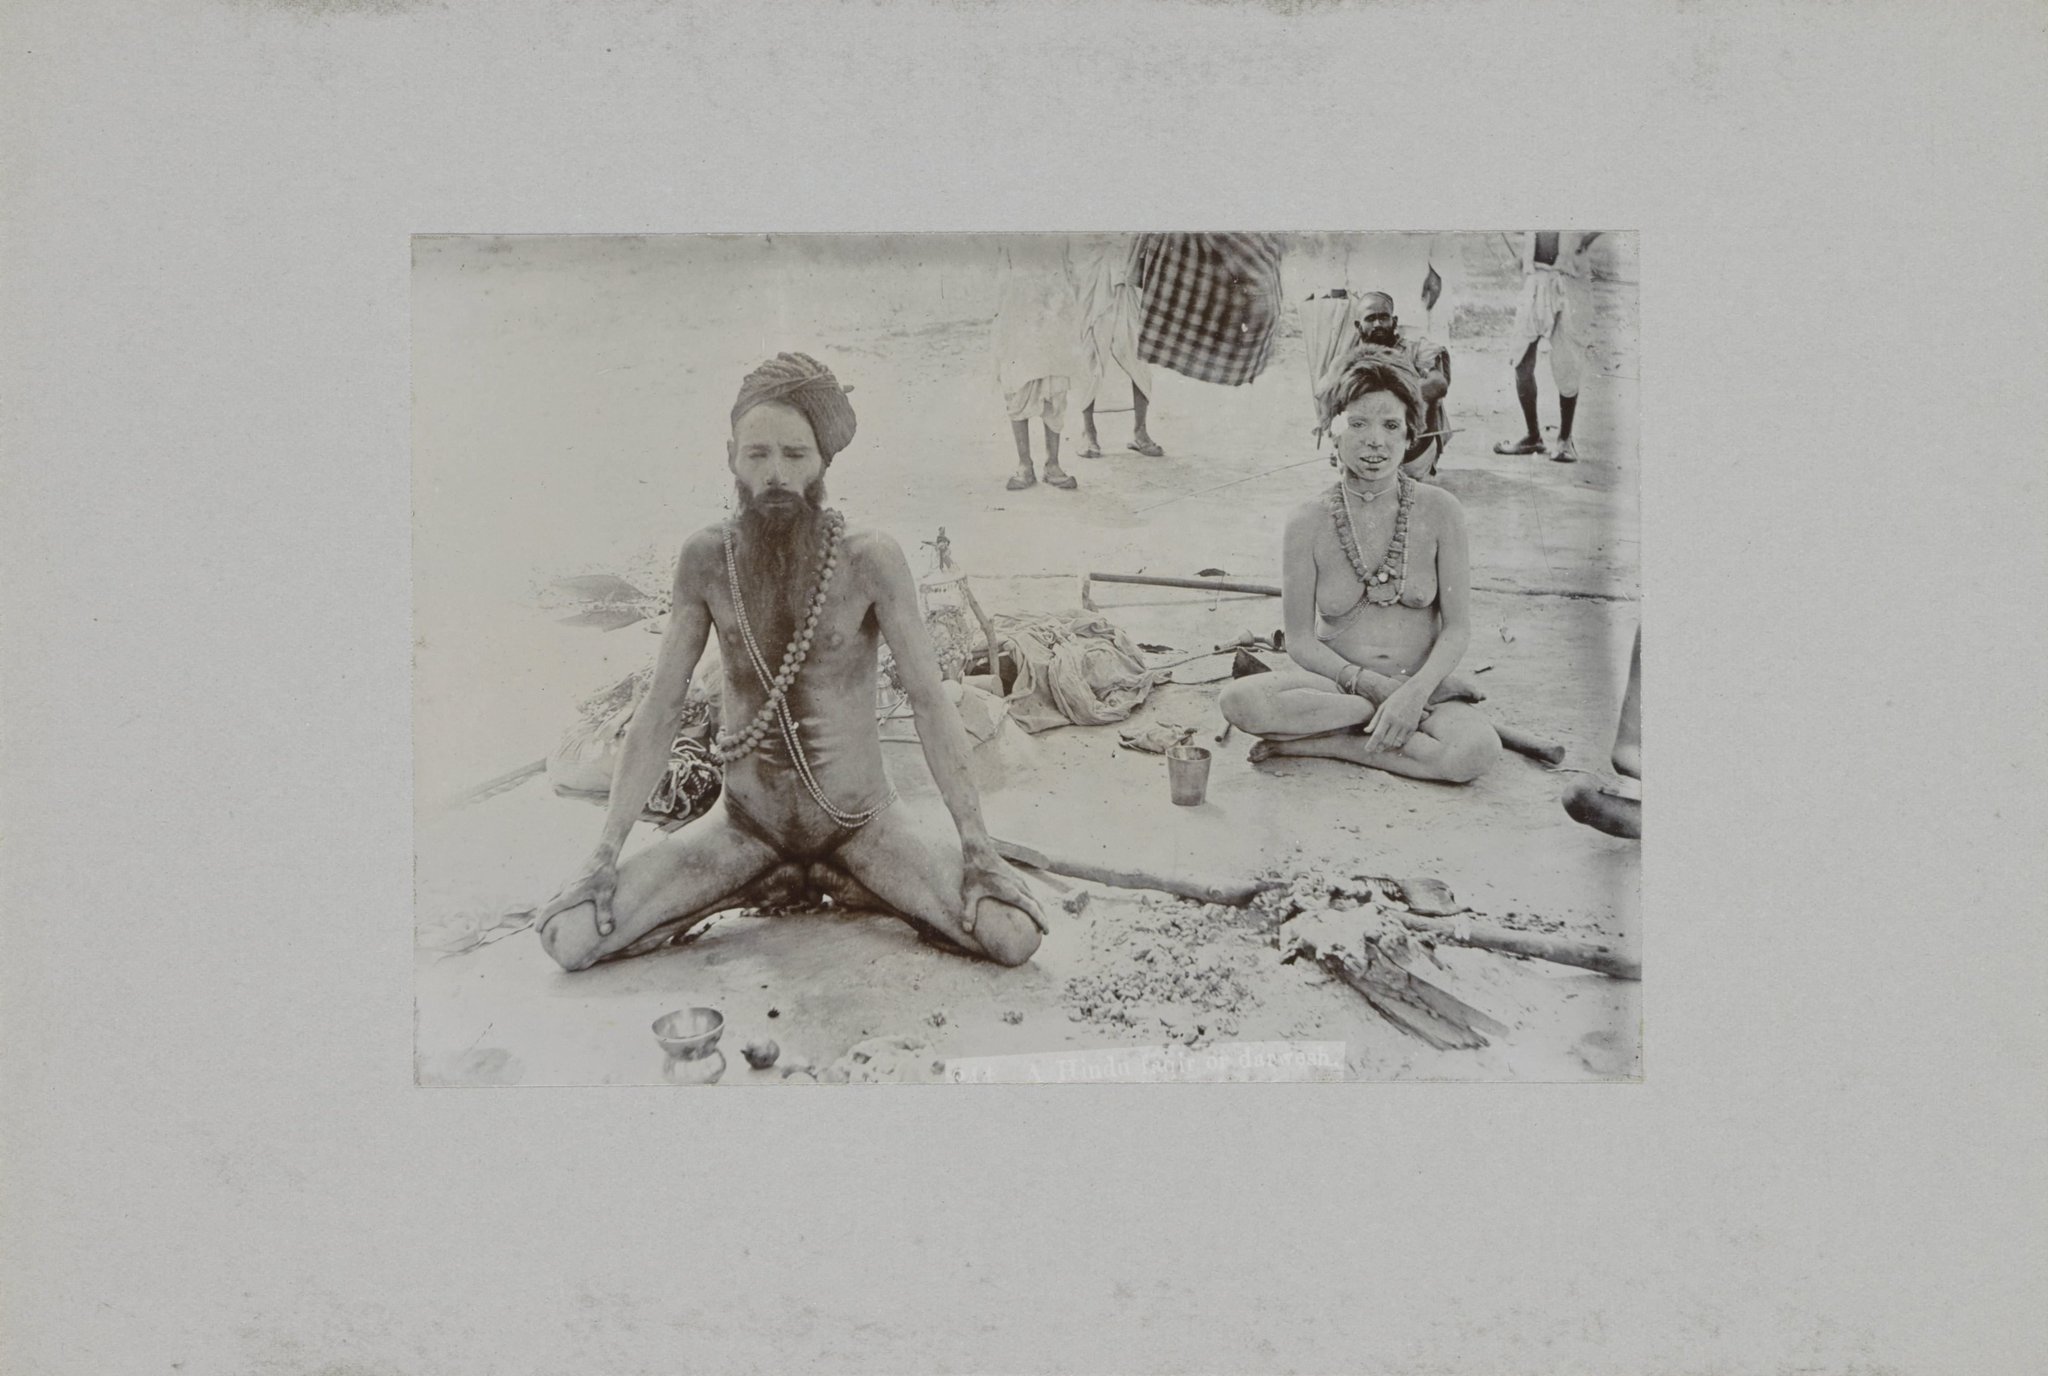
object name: photograph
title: Naked Hindu fakir and woman, Varanasi, Uttar Pradesh, India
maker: Anonymous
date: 1895-1915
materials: cardboard, paper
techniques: gelatin silver print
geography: varanasi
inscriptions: inscription: ‘244 A Hindu faqir or darwesh’, annotation: ‘13a Benares (Fakir).’